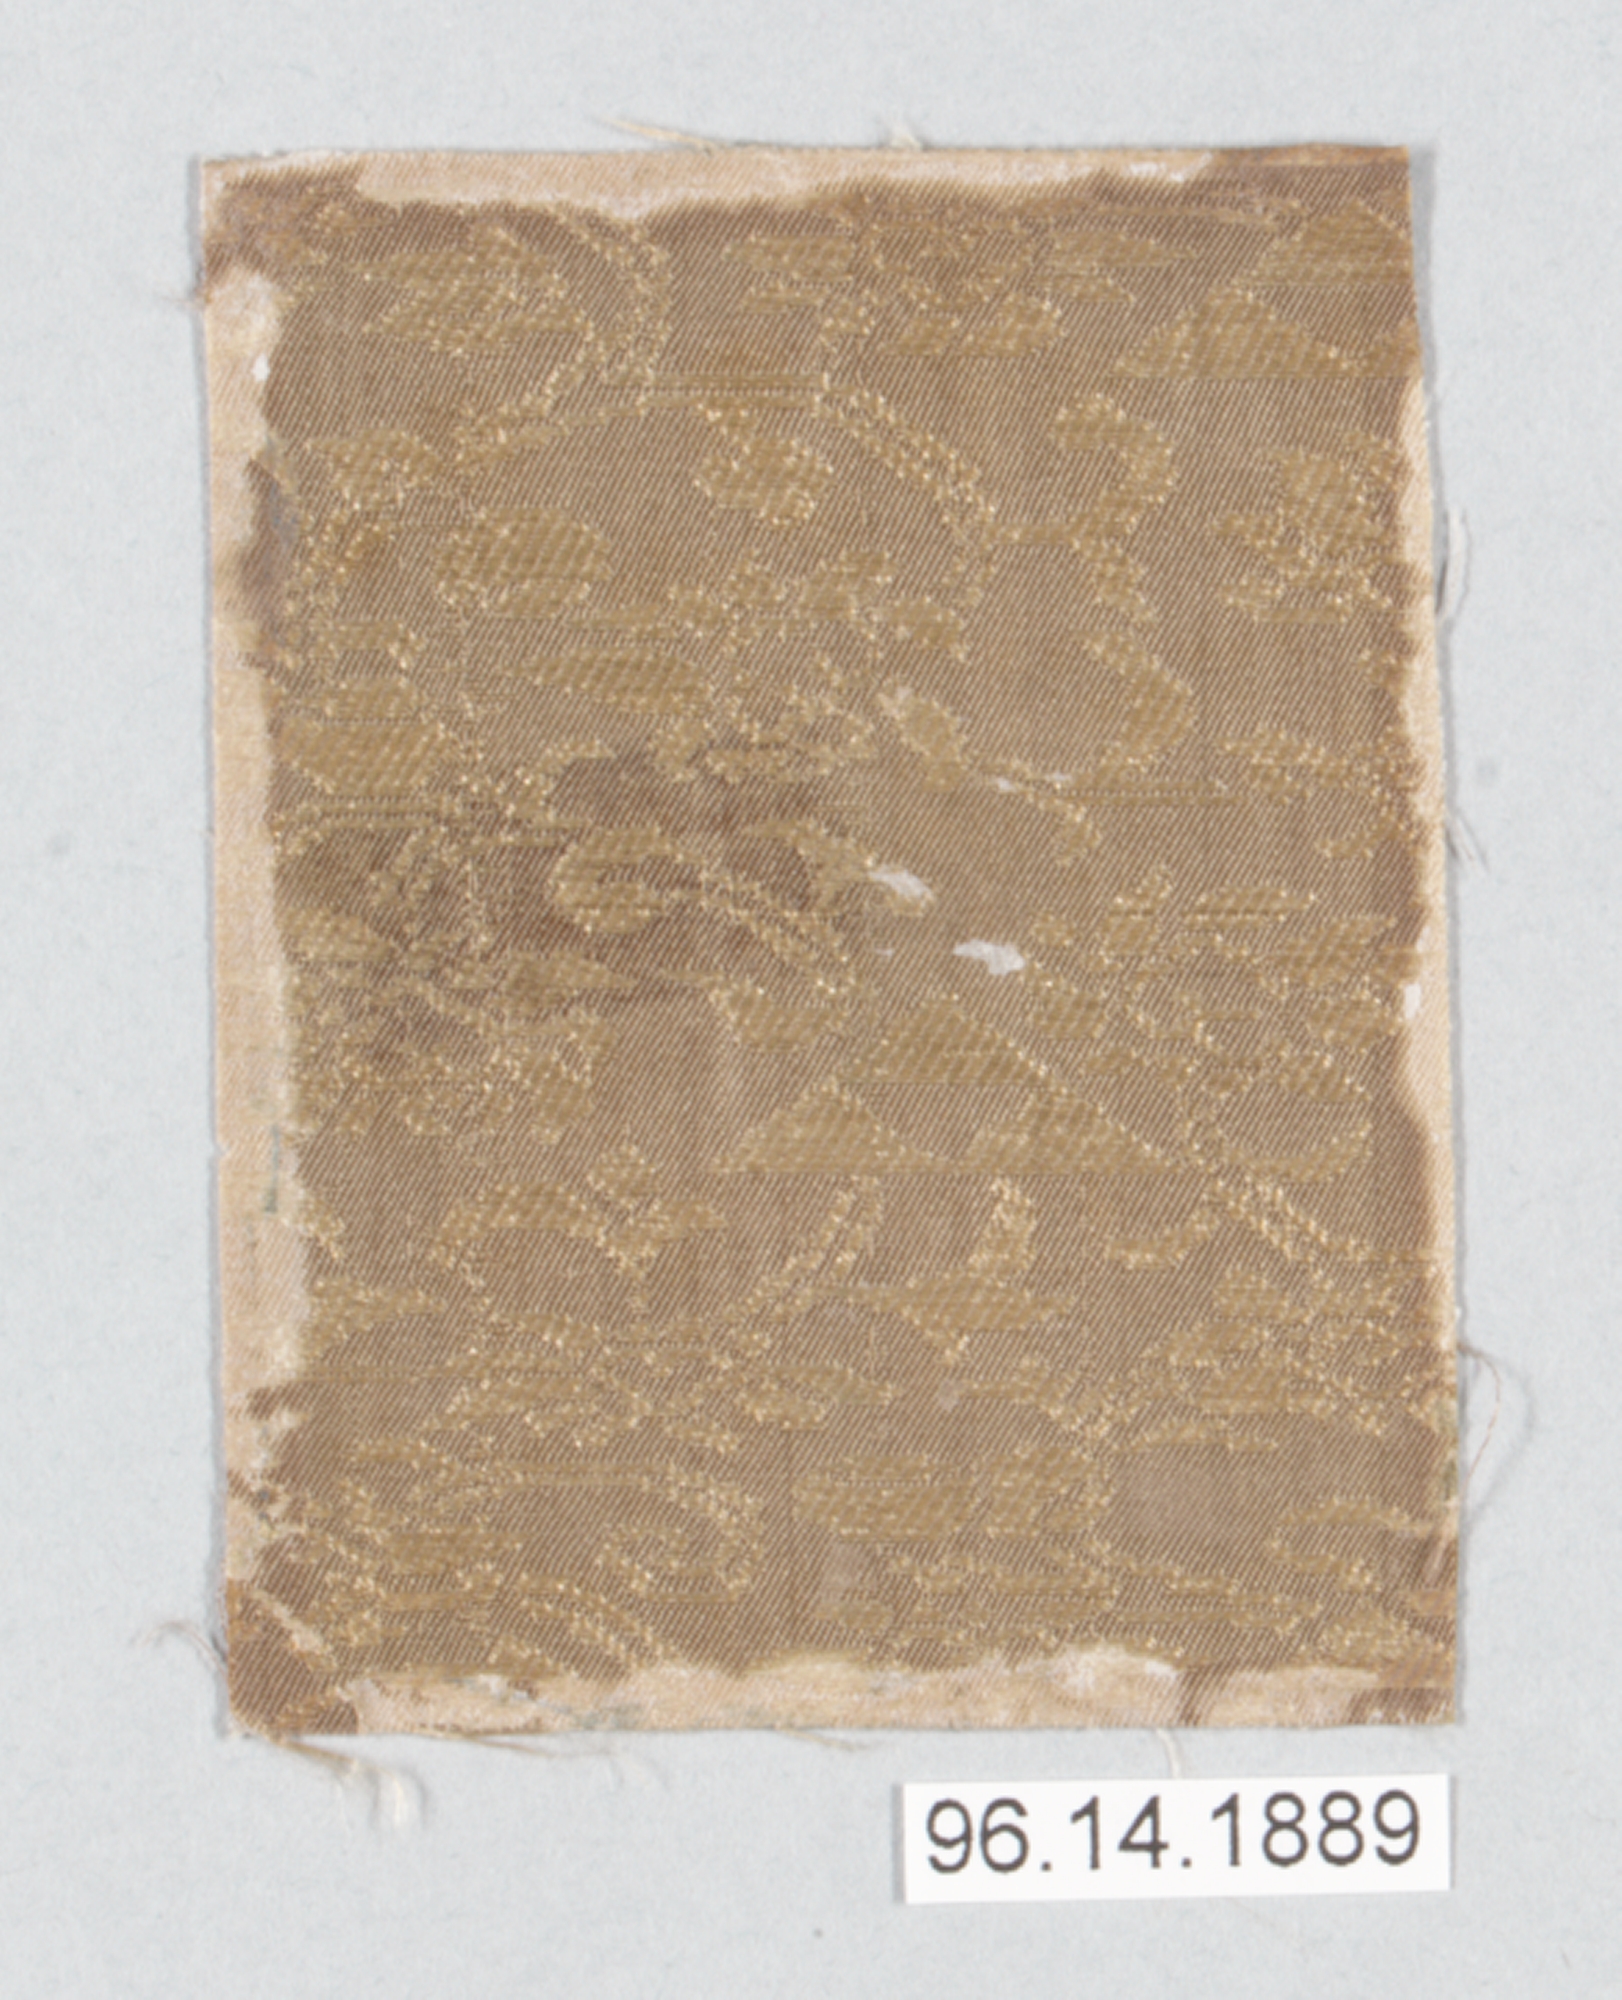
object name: piece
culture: japanese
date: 1701-1900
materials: silk